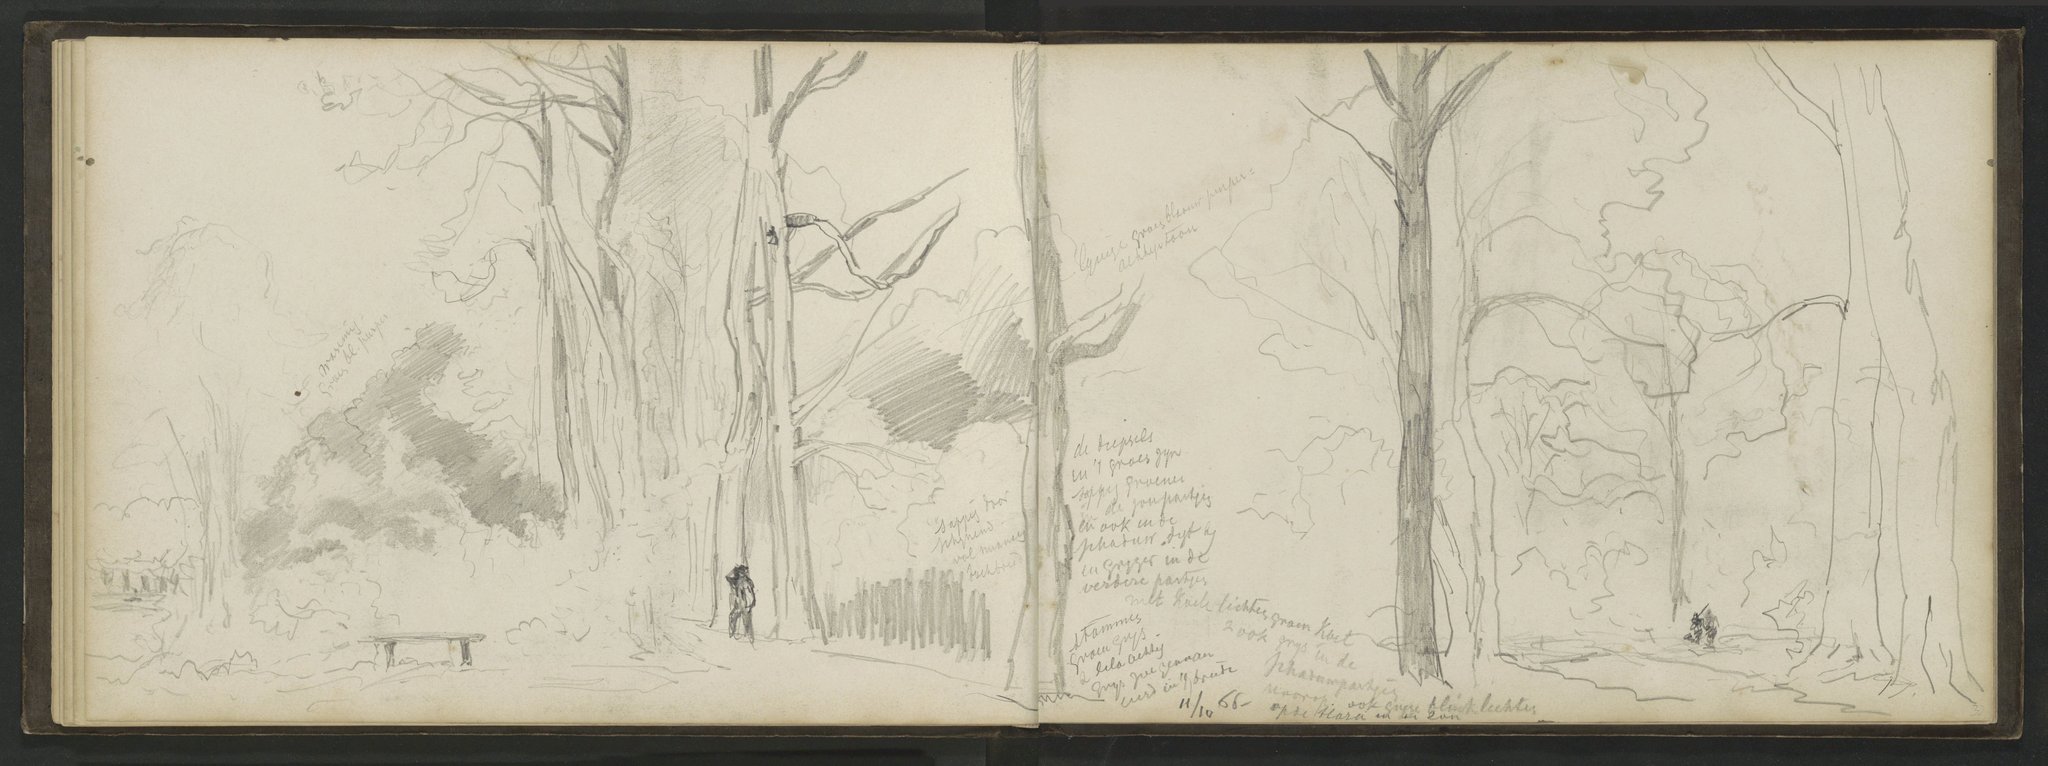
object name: sketchbook leaf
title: Wandelaar op een bospad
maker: johannes tavenraat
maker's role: draughtsman, painter, print maker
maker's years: 1809-1881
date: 1858-1870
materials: paper, pencil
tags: forest, wood, forest path or lane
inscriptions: kleurnotitie, handgeschreven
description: Blad 31 verso en 32 recto uit een schetsboek met 57 bladen.